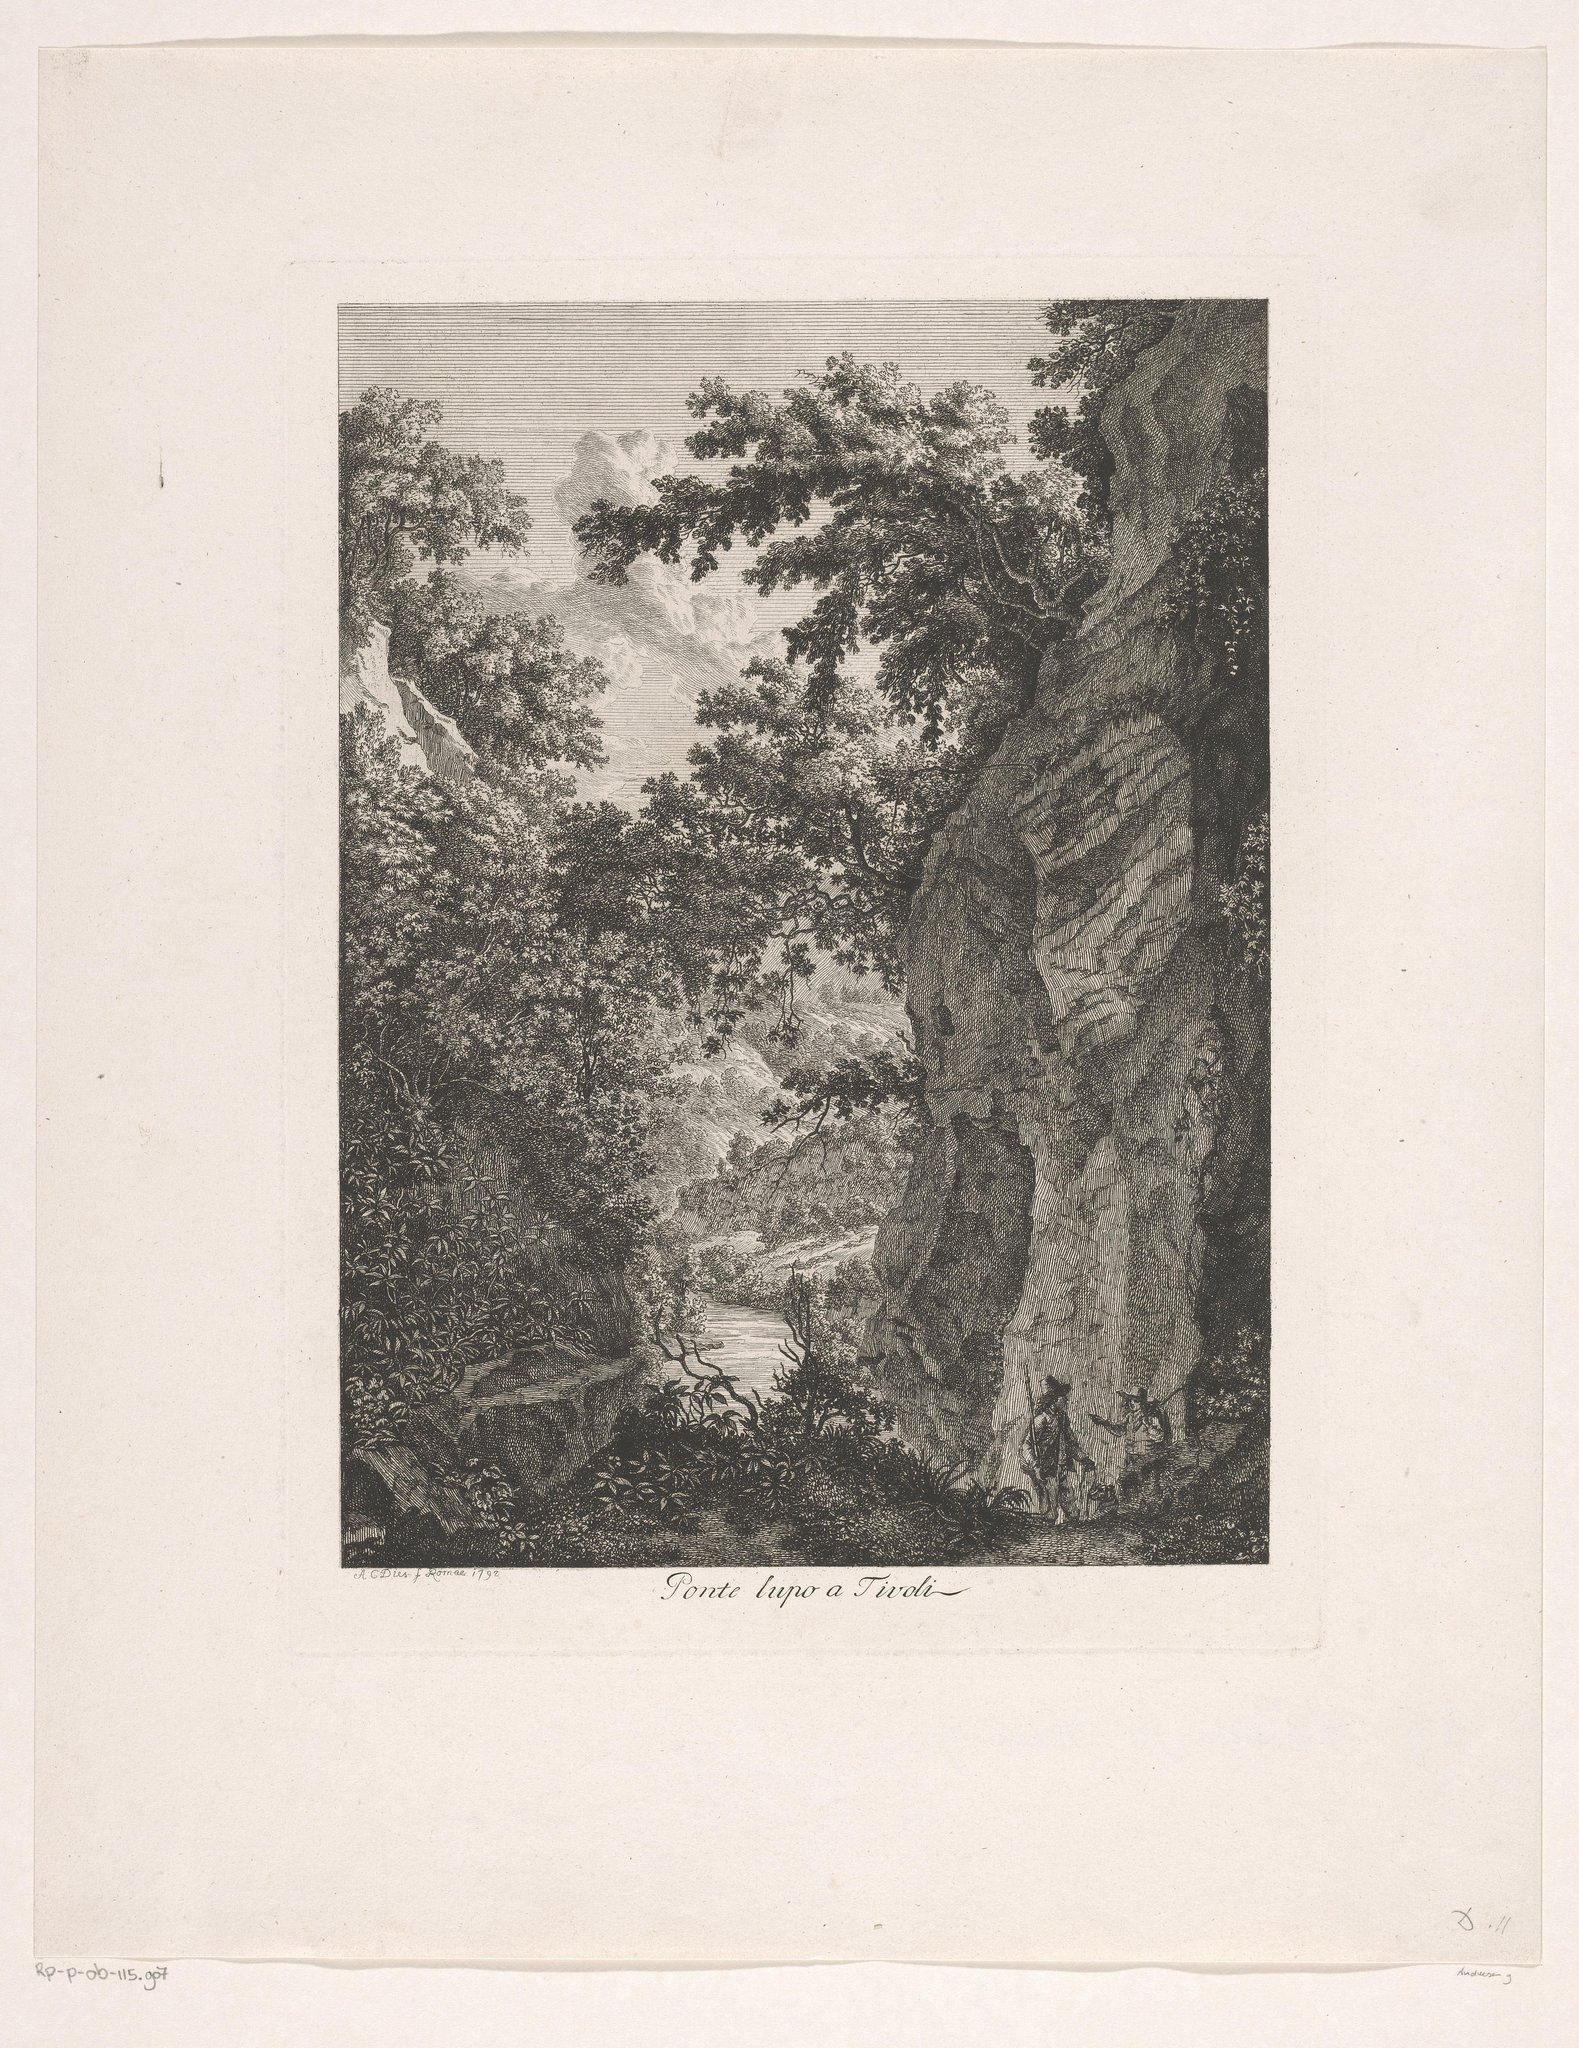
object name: print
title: Ponte Lupo a Tivoli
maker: albert christoph dies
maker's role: painter, print maker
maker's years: 1755-1822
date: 1792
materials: paper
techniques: etching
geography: rome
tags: walking, hiking (recreation), river, landscapes in the temperate zone, walking the dog, rock-formations, tivoli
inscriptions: collector's mark: Lugt 2228